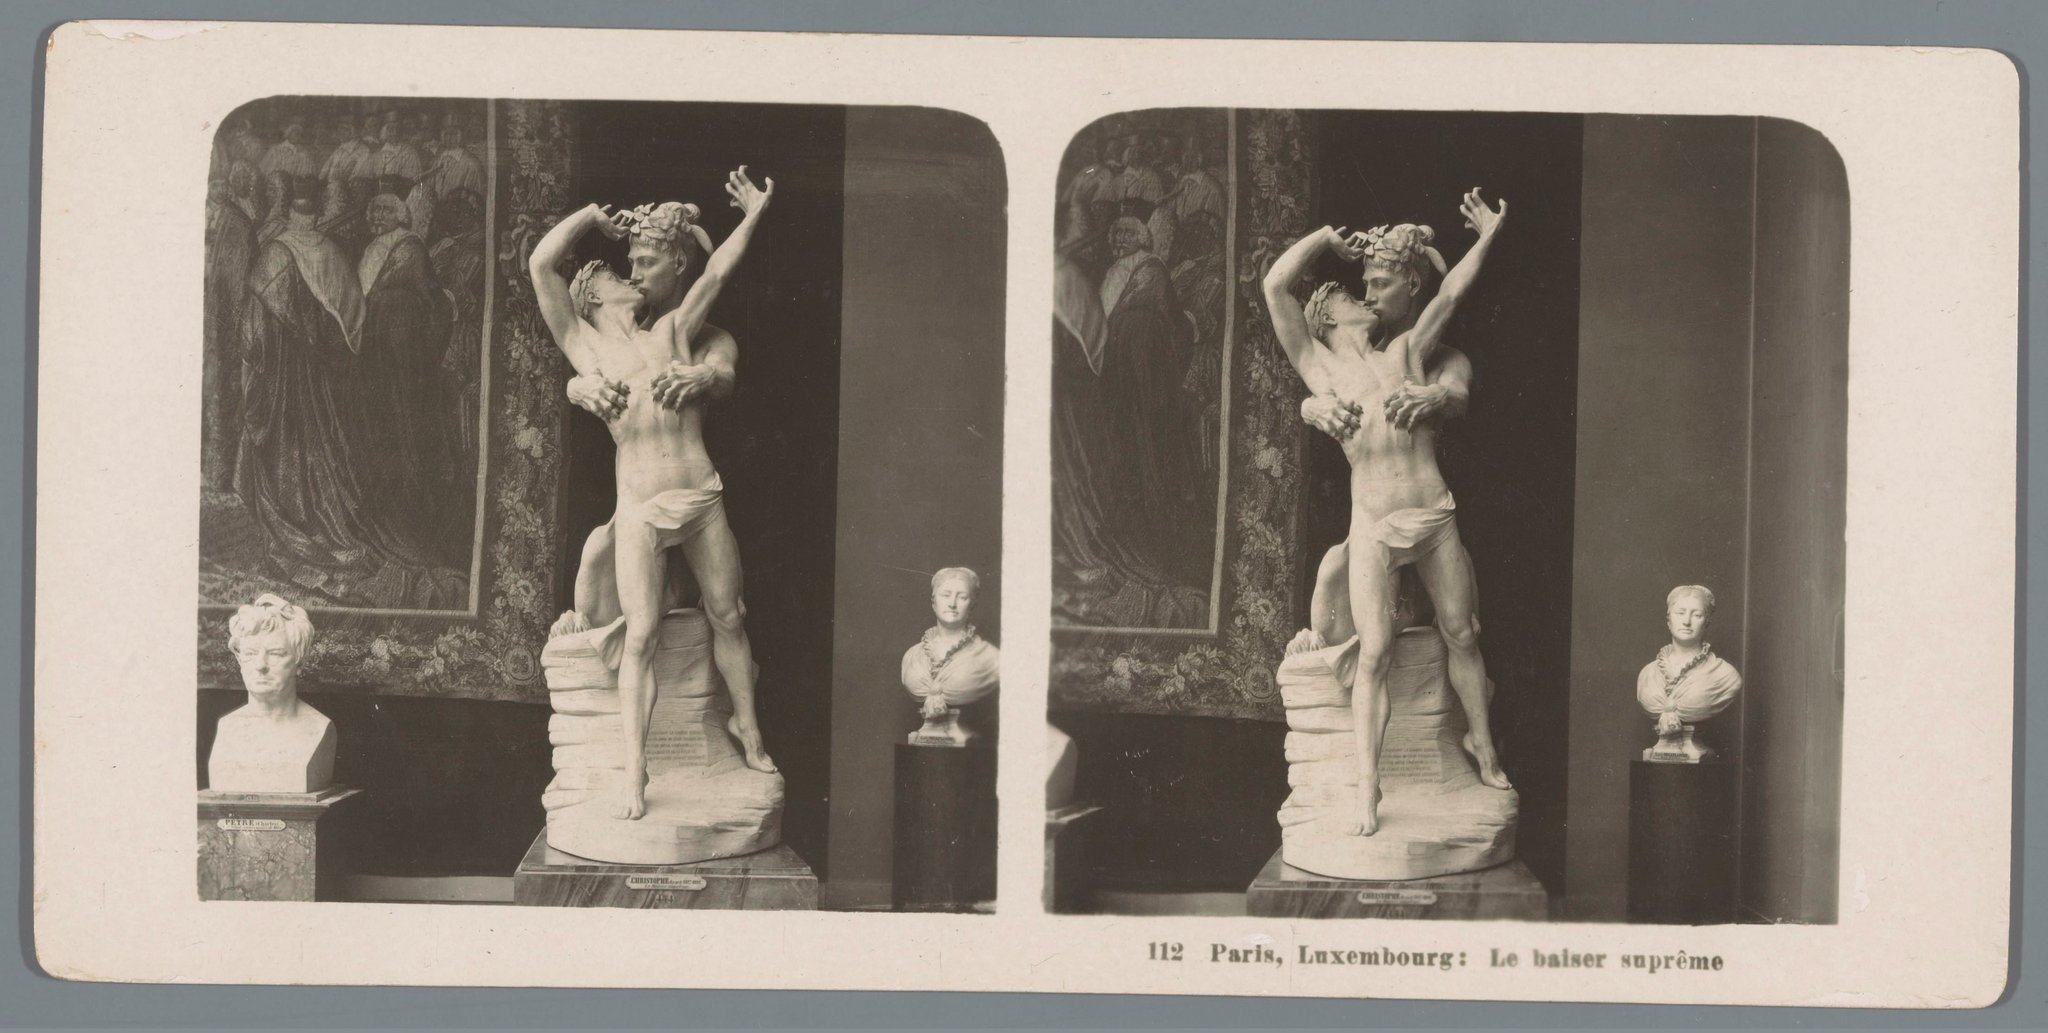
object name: stereograph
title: Sculptuur in het Musée du Luxembourg te Parijs, voorstellende een sfinx kust een jongeman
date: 1895-1905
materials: cardboard, photographic support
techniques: gelatin silver print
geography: musée du luxembourg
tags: sphinx (lion/woman); 'sfinge' (ripa), embracing each other, kissing, permanent exhibition, museum, sculpture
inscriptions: number: ‘112’